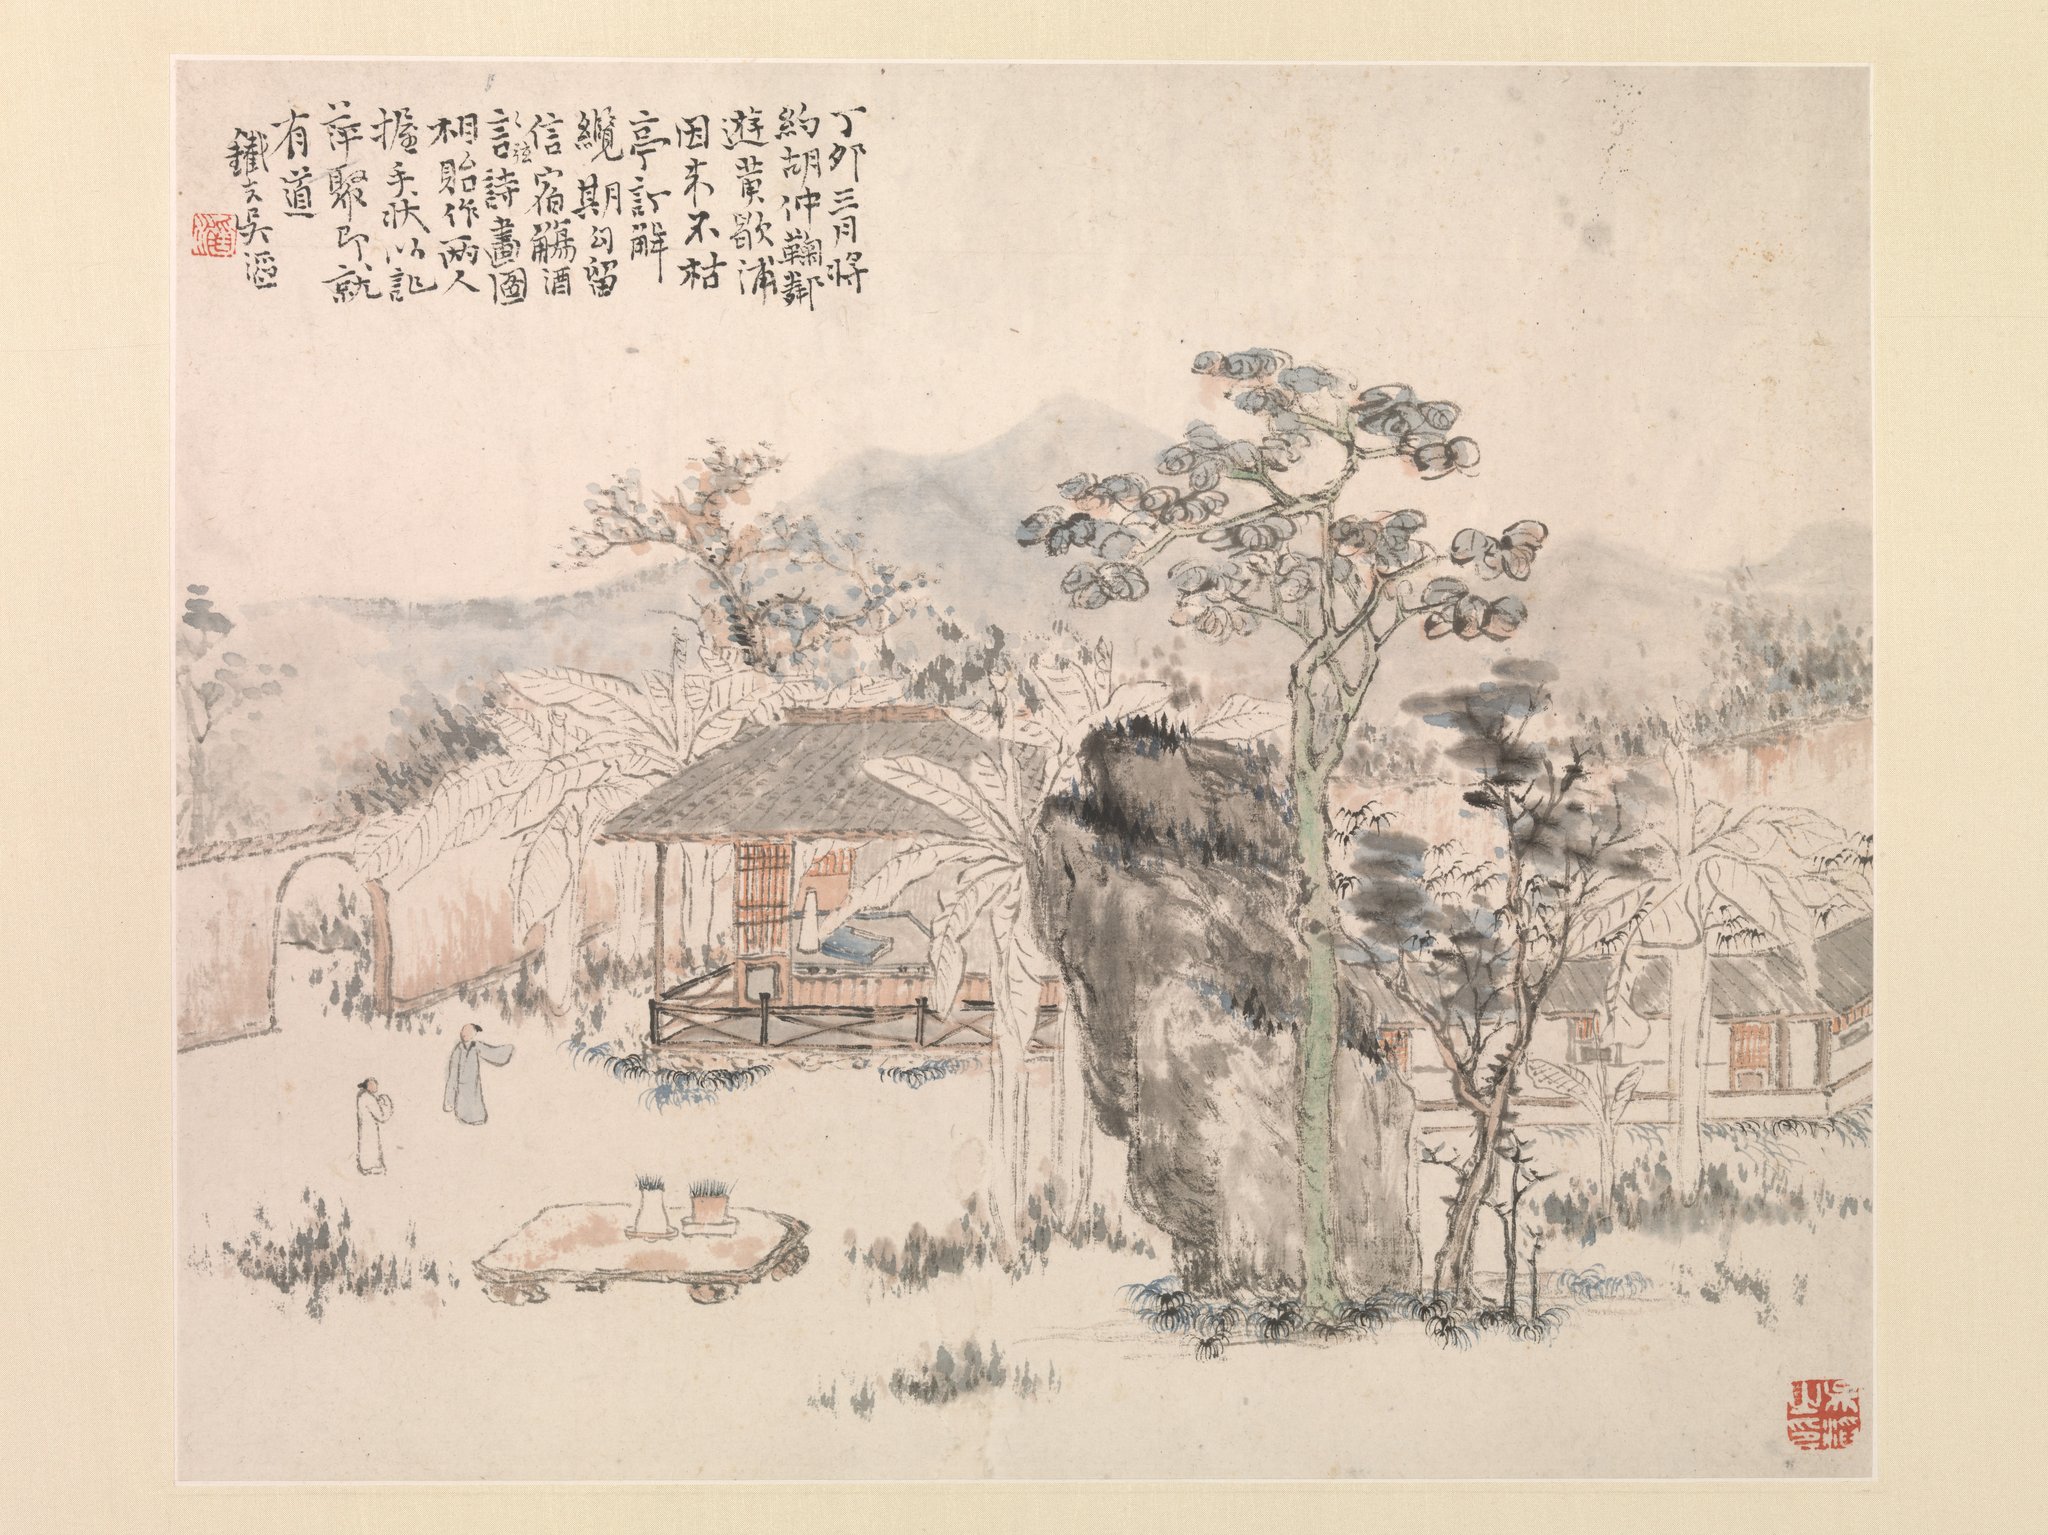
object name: album leaf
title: Garden scene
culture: chinese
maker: wu tao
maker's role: artist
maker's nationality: chinese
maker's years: 1840-1895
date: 1867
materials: ink, paper